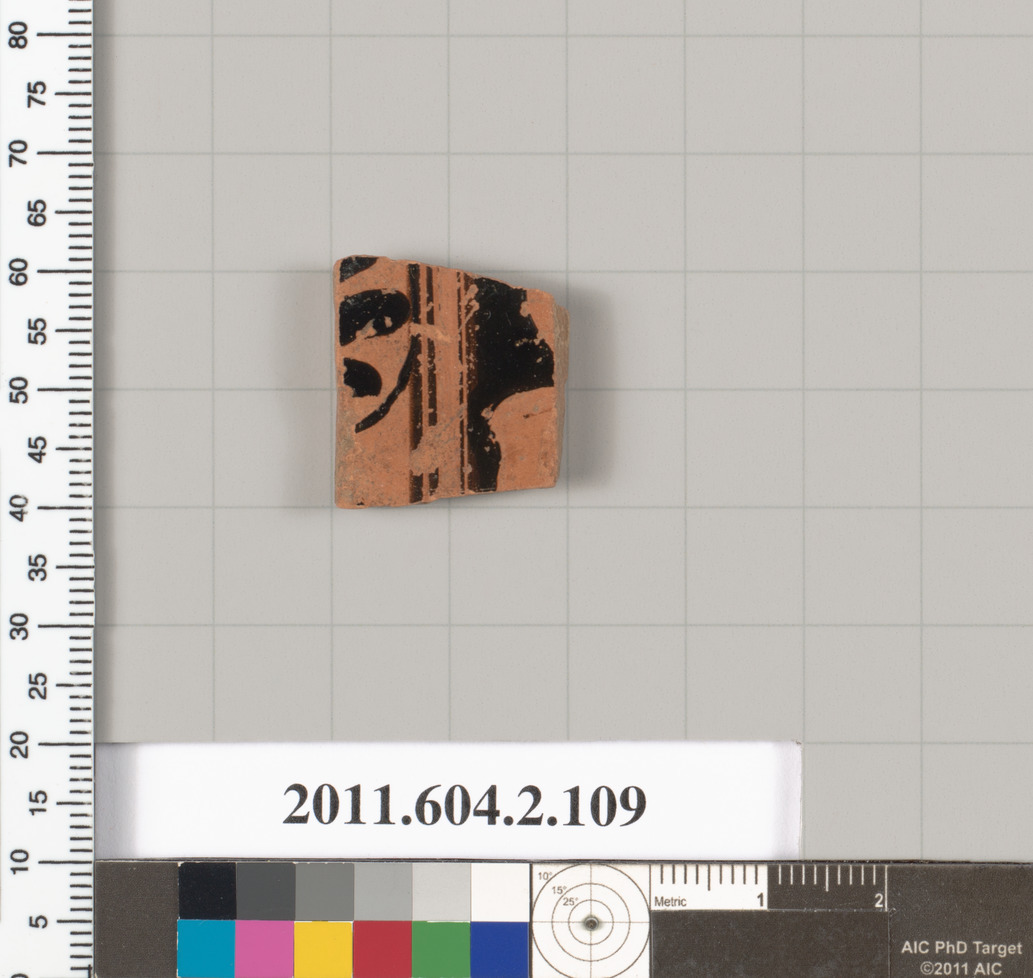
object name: pelike fragment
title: Terracotta fragment of a pelike (jar)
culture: greek, attic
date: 520-500 BCE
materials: terracotta